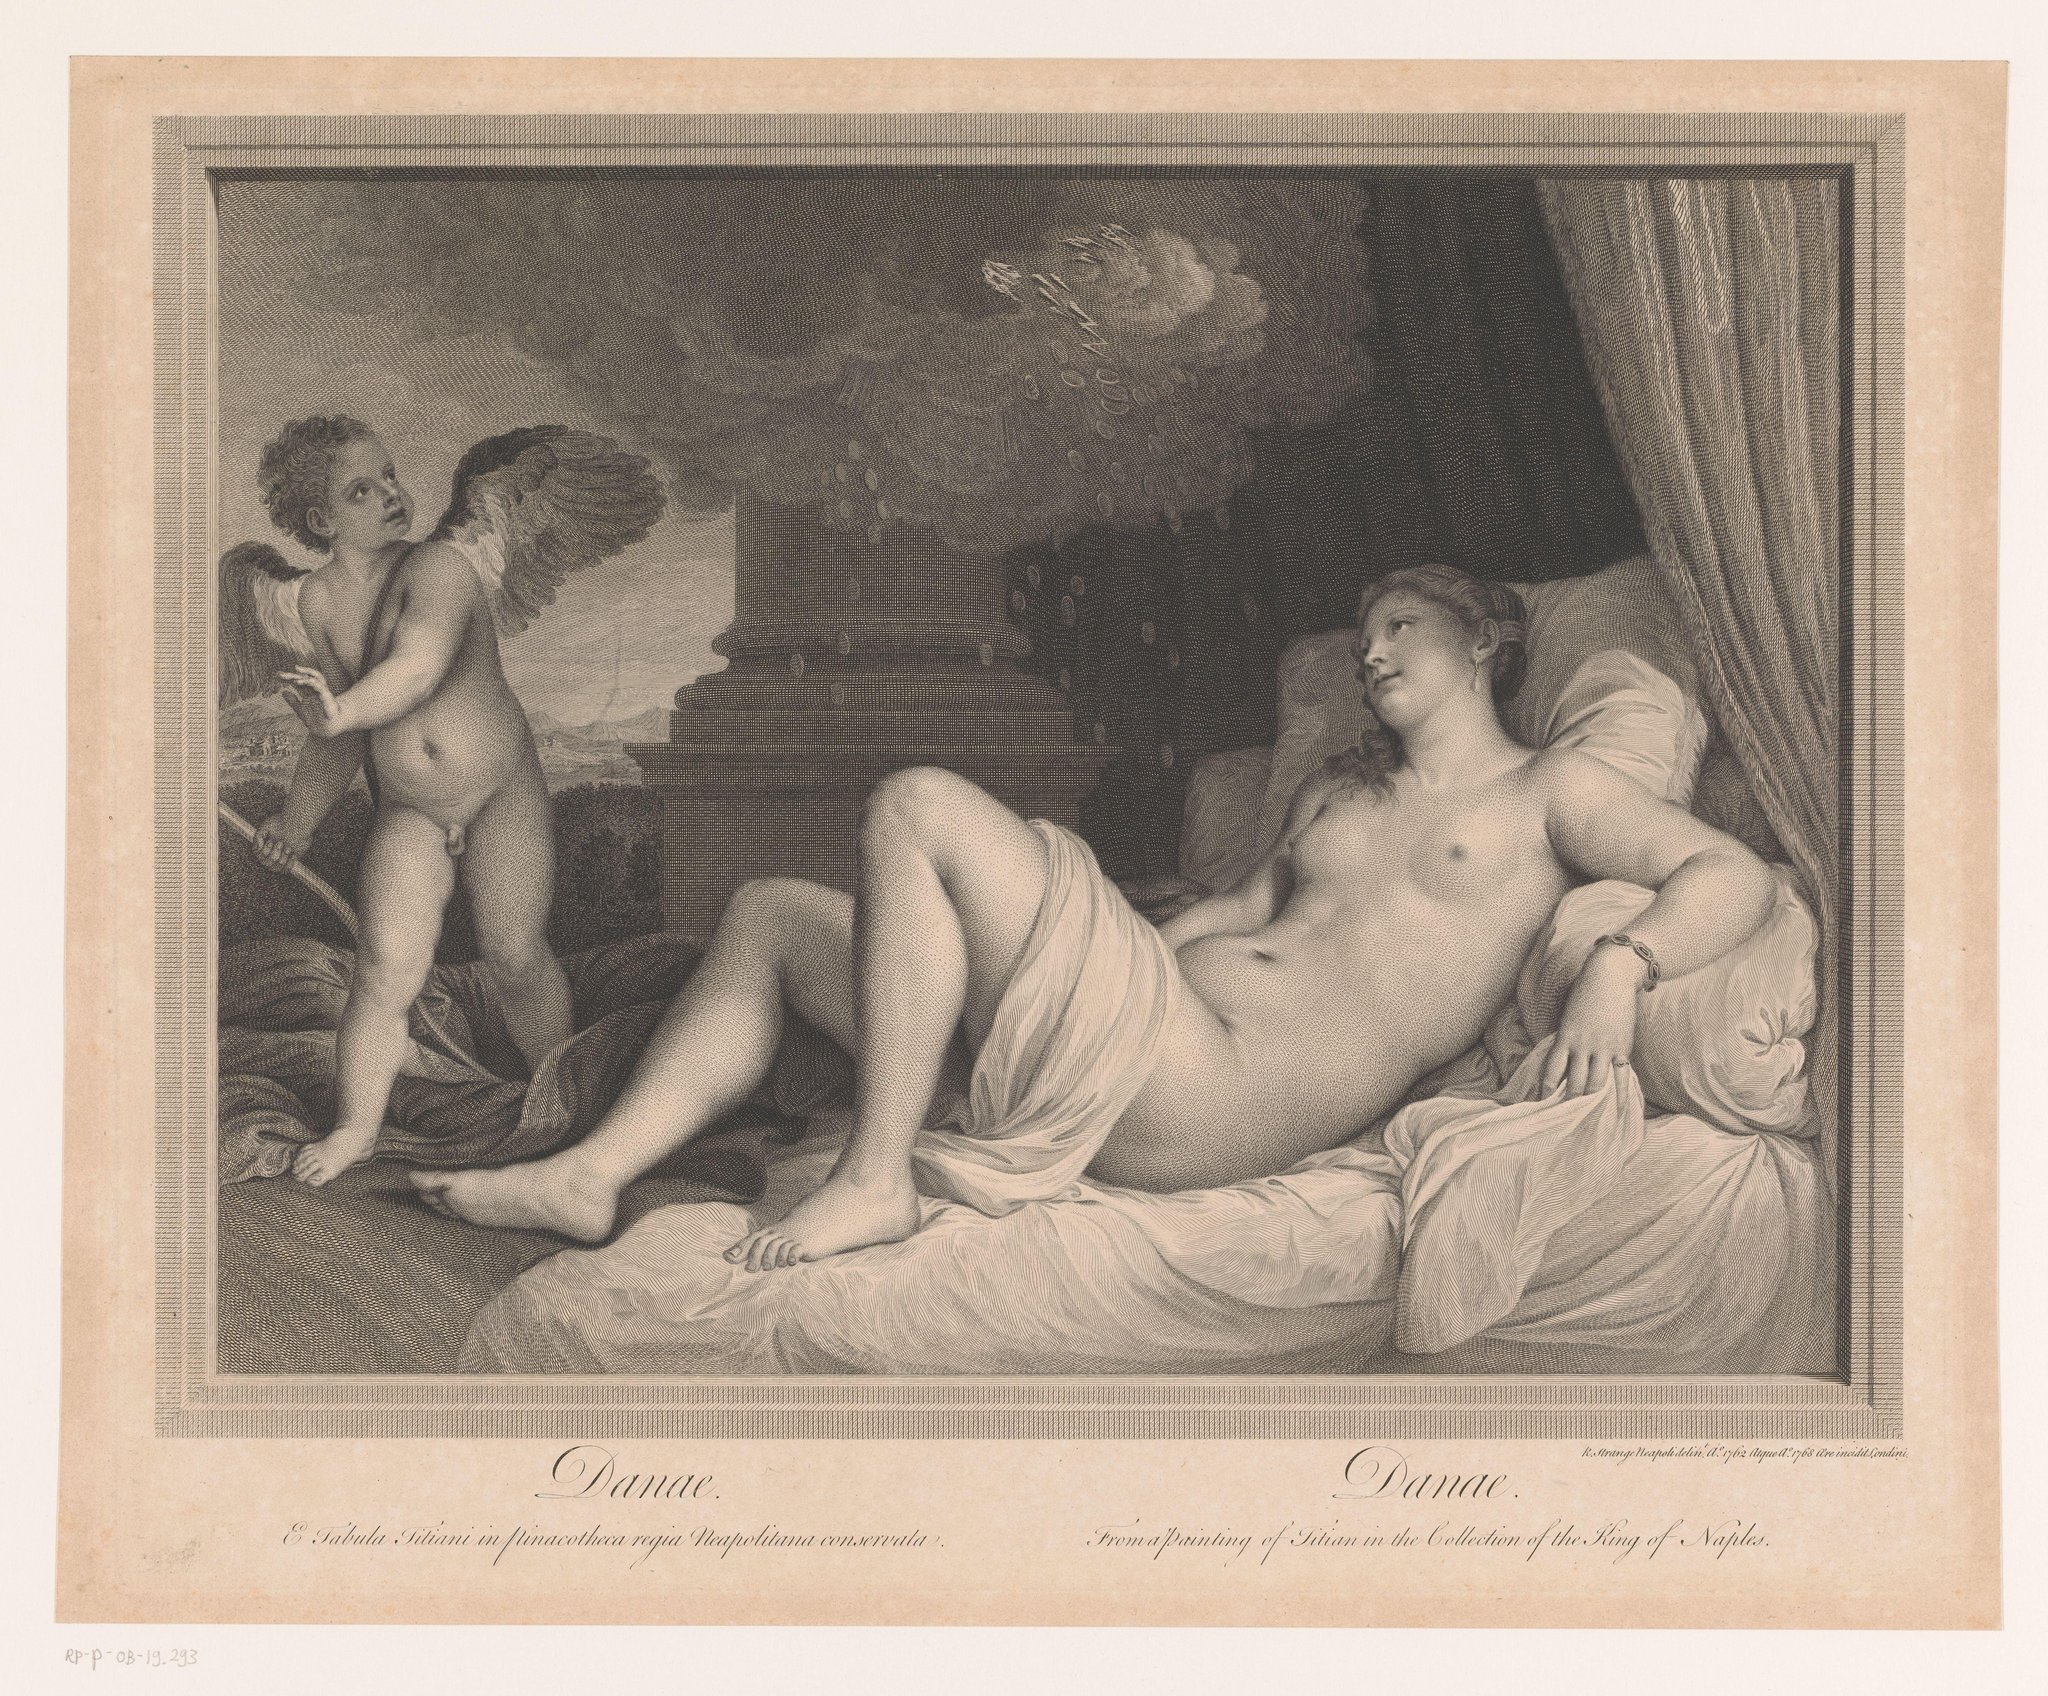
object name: print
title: Danae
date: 1762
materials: paper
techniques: engraving, etching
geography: naples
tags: jupiter wooing danae; she is usually lying in bed receiving a shower of gold, (story of) danae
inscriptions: collector's mark: Lugt 2228